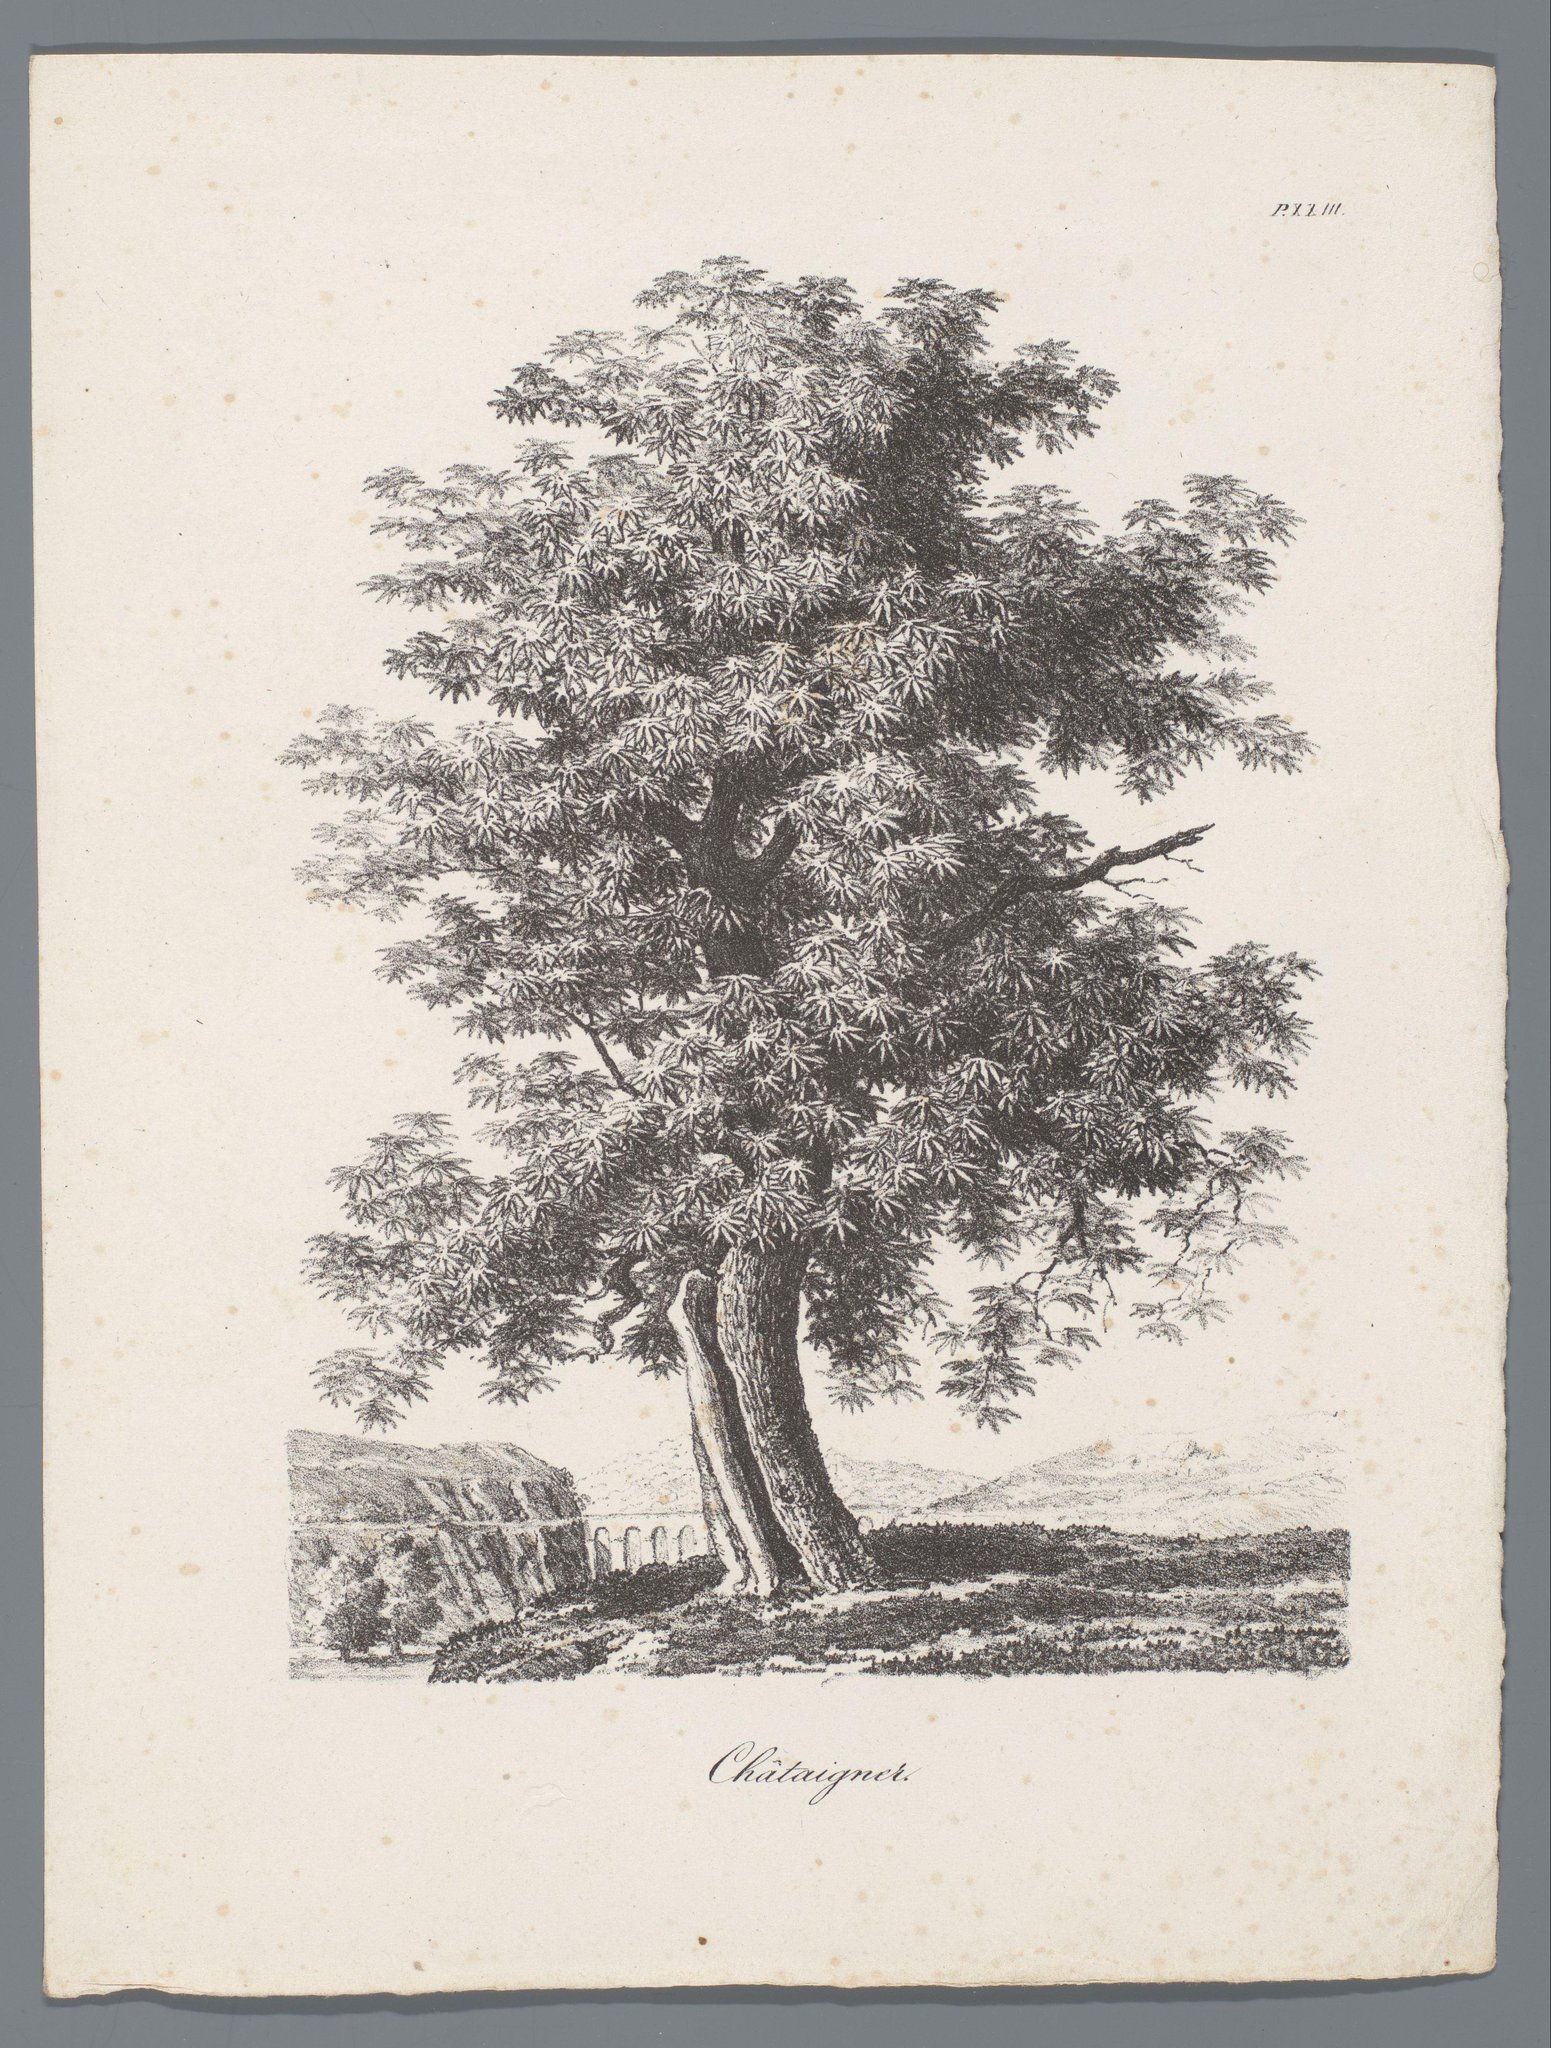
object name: print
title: Tamme kastanje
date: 1820-1835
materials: paper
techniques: lithograph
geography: paris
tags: trees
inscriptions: collector's mark: Lugt 2228